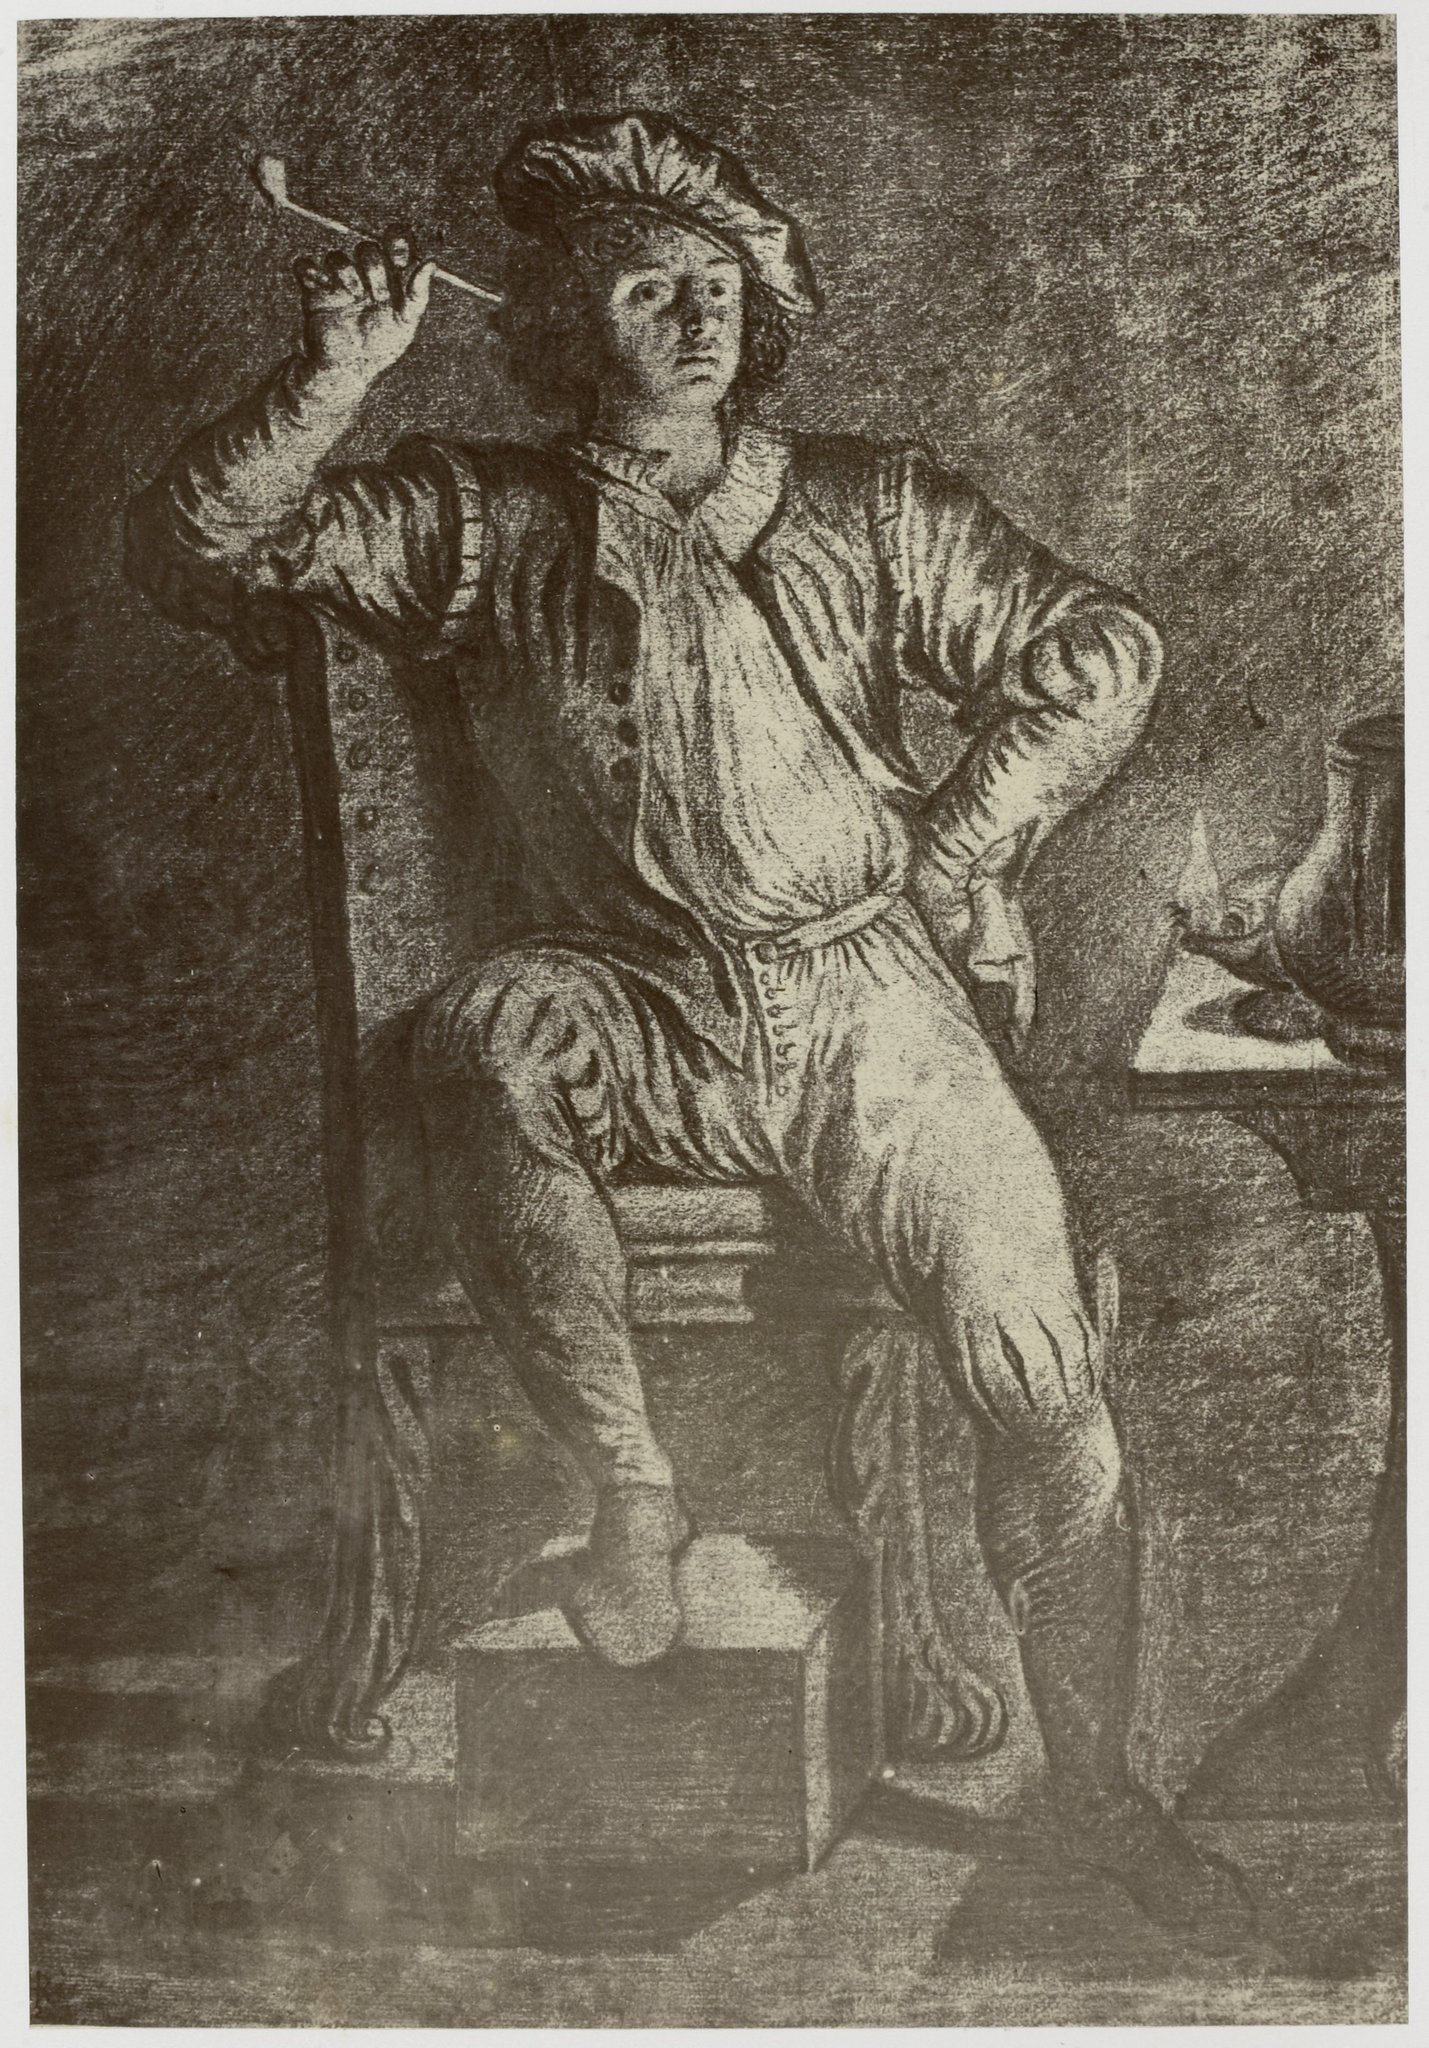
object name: photograph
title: Schalkin [Schalcken?], A German Student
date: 1855-1858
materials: cardboard, paper, photographic support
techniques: albumen print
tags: drawing, sketch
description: Fotoreproductie van tekening in 'The Reveley Collection of Drawings at Brynygwin', afb. 27.